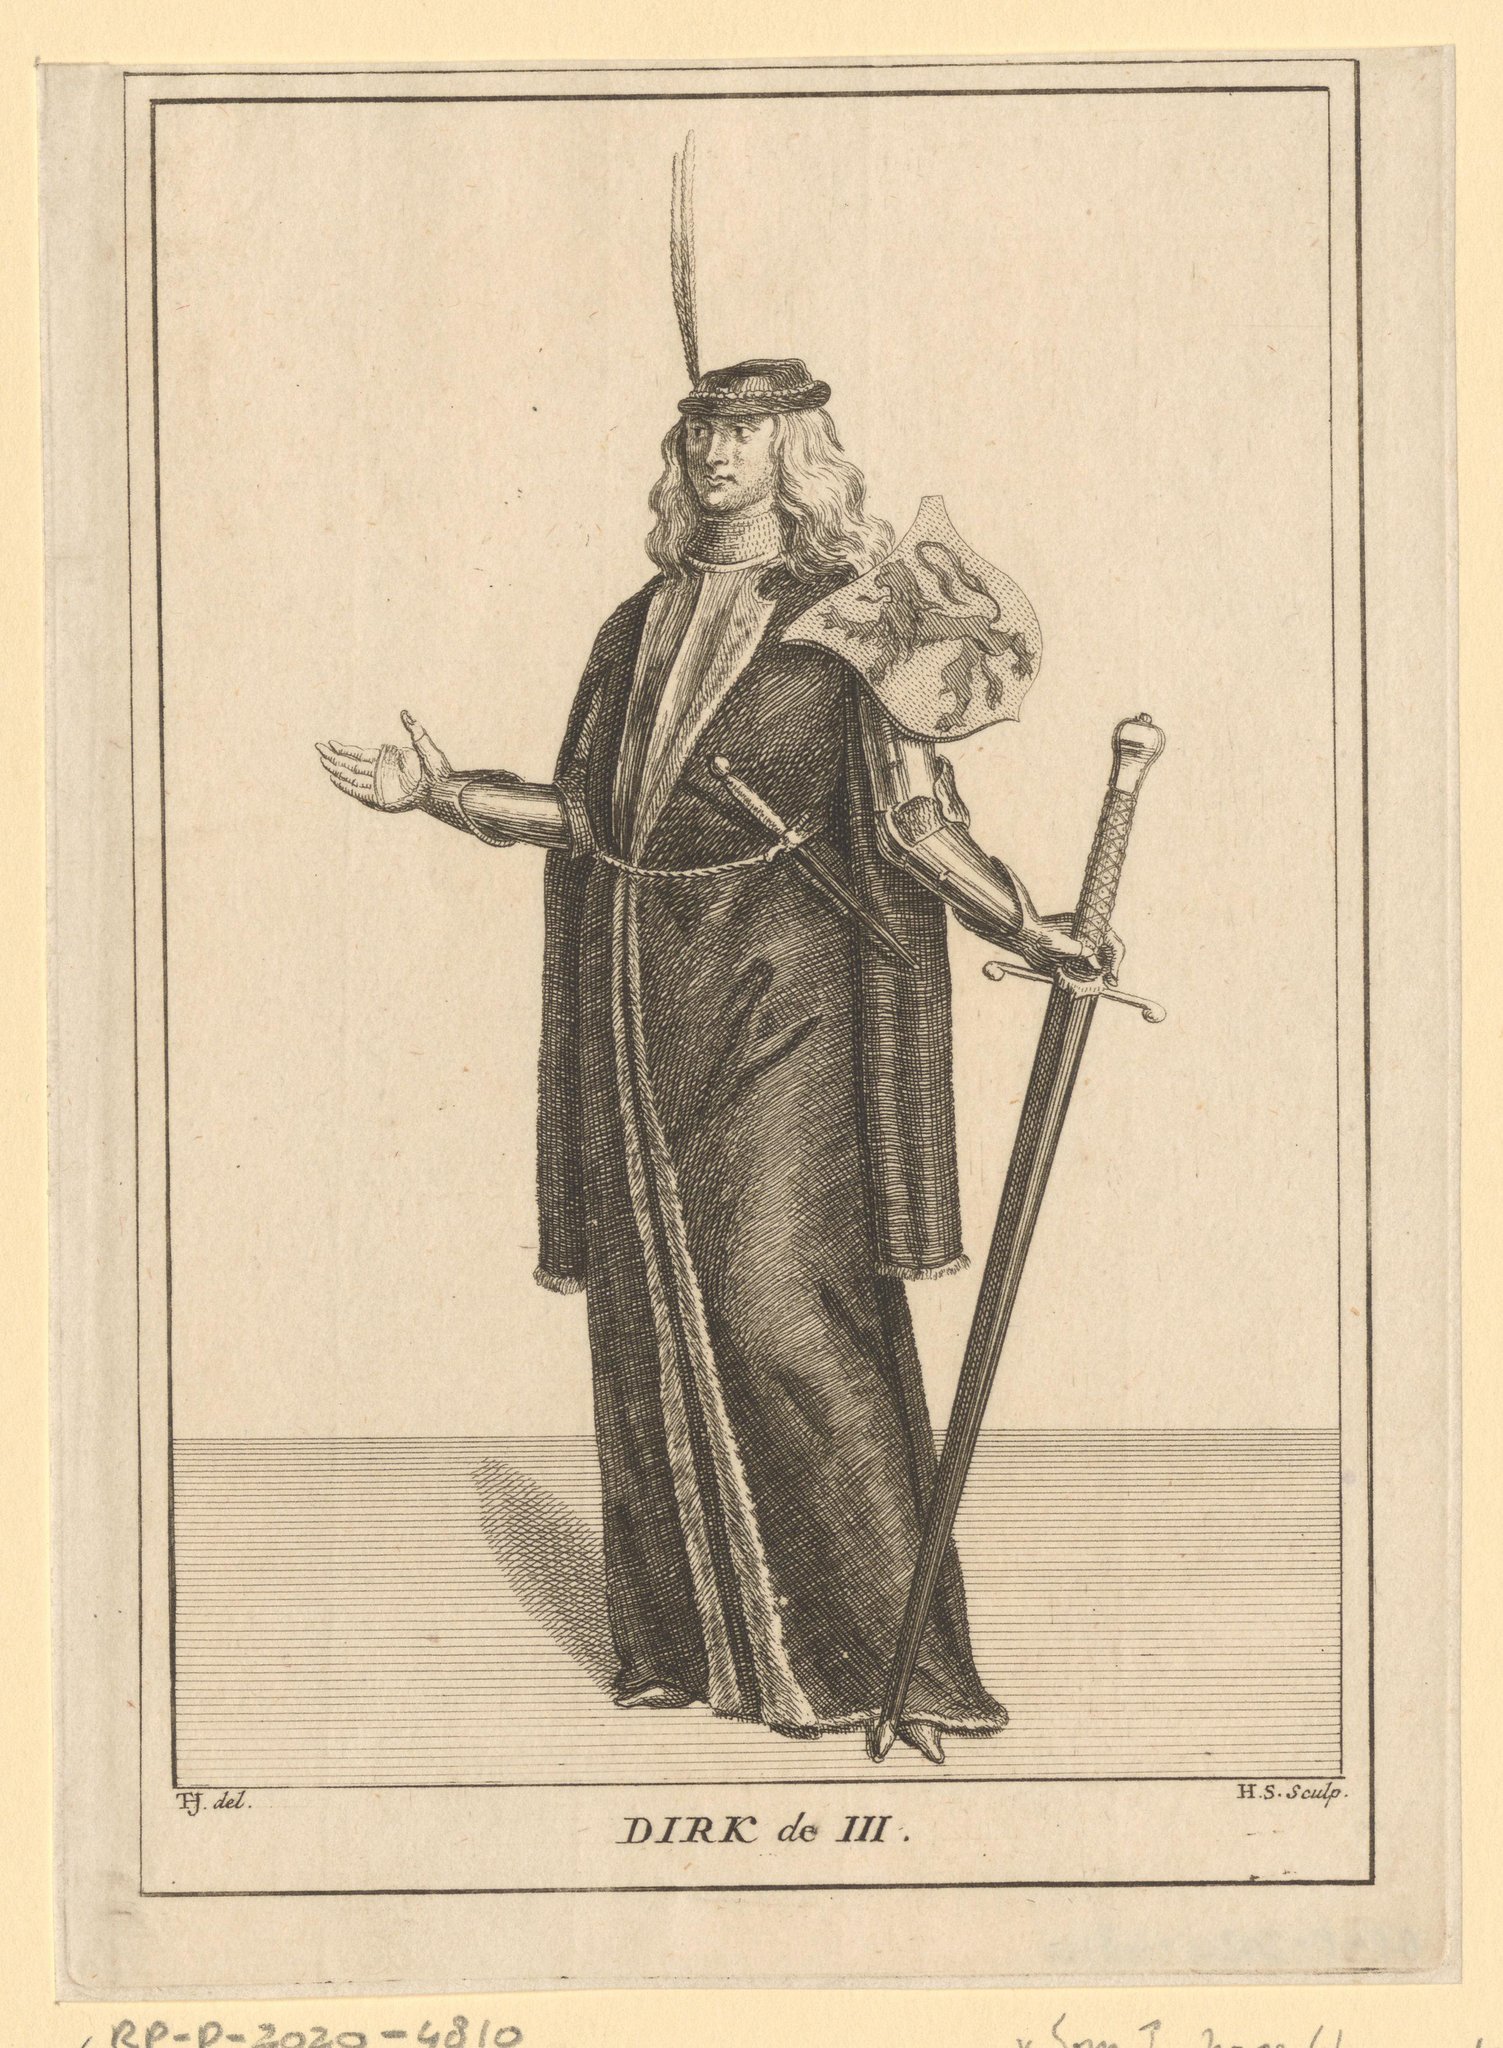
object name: print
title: Portret van Dirk III, graaf van Holland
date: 1745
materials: paper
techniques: etching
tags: historical persons, hacking and thrusting weapons: sword, ruler, sovereign, armorial bearing, heraldry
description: Prent waarschijnlijk uit: Langendyk, Pieter. De graaven van Holland, in jaardichten beschreven. Haarlem: Jan Bosch, 1745, dl. 1.